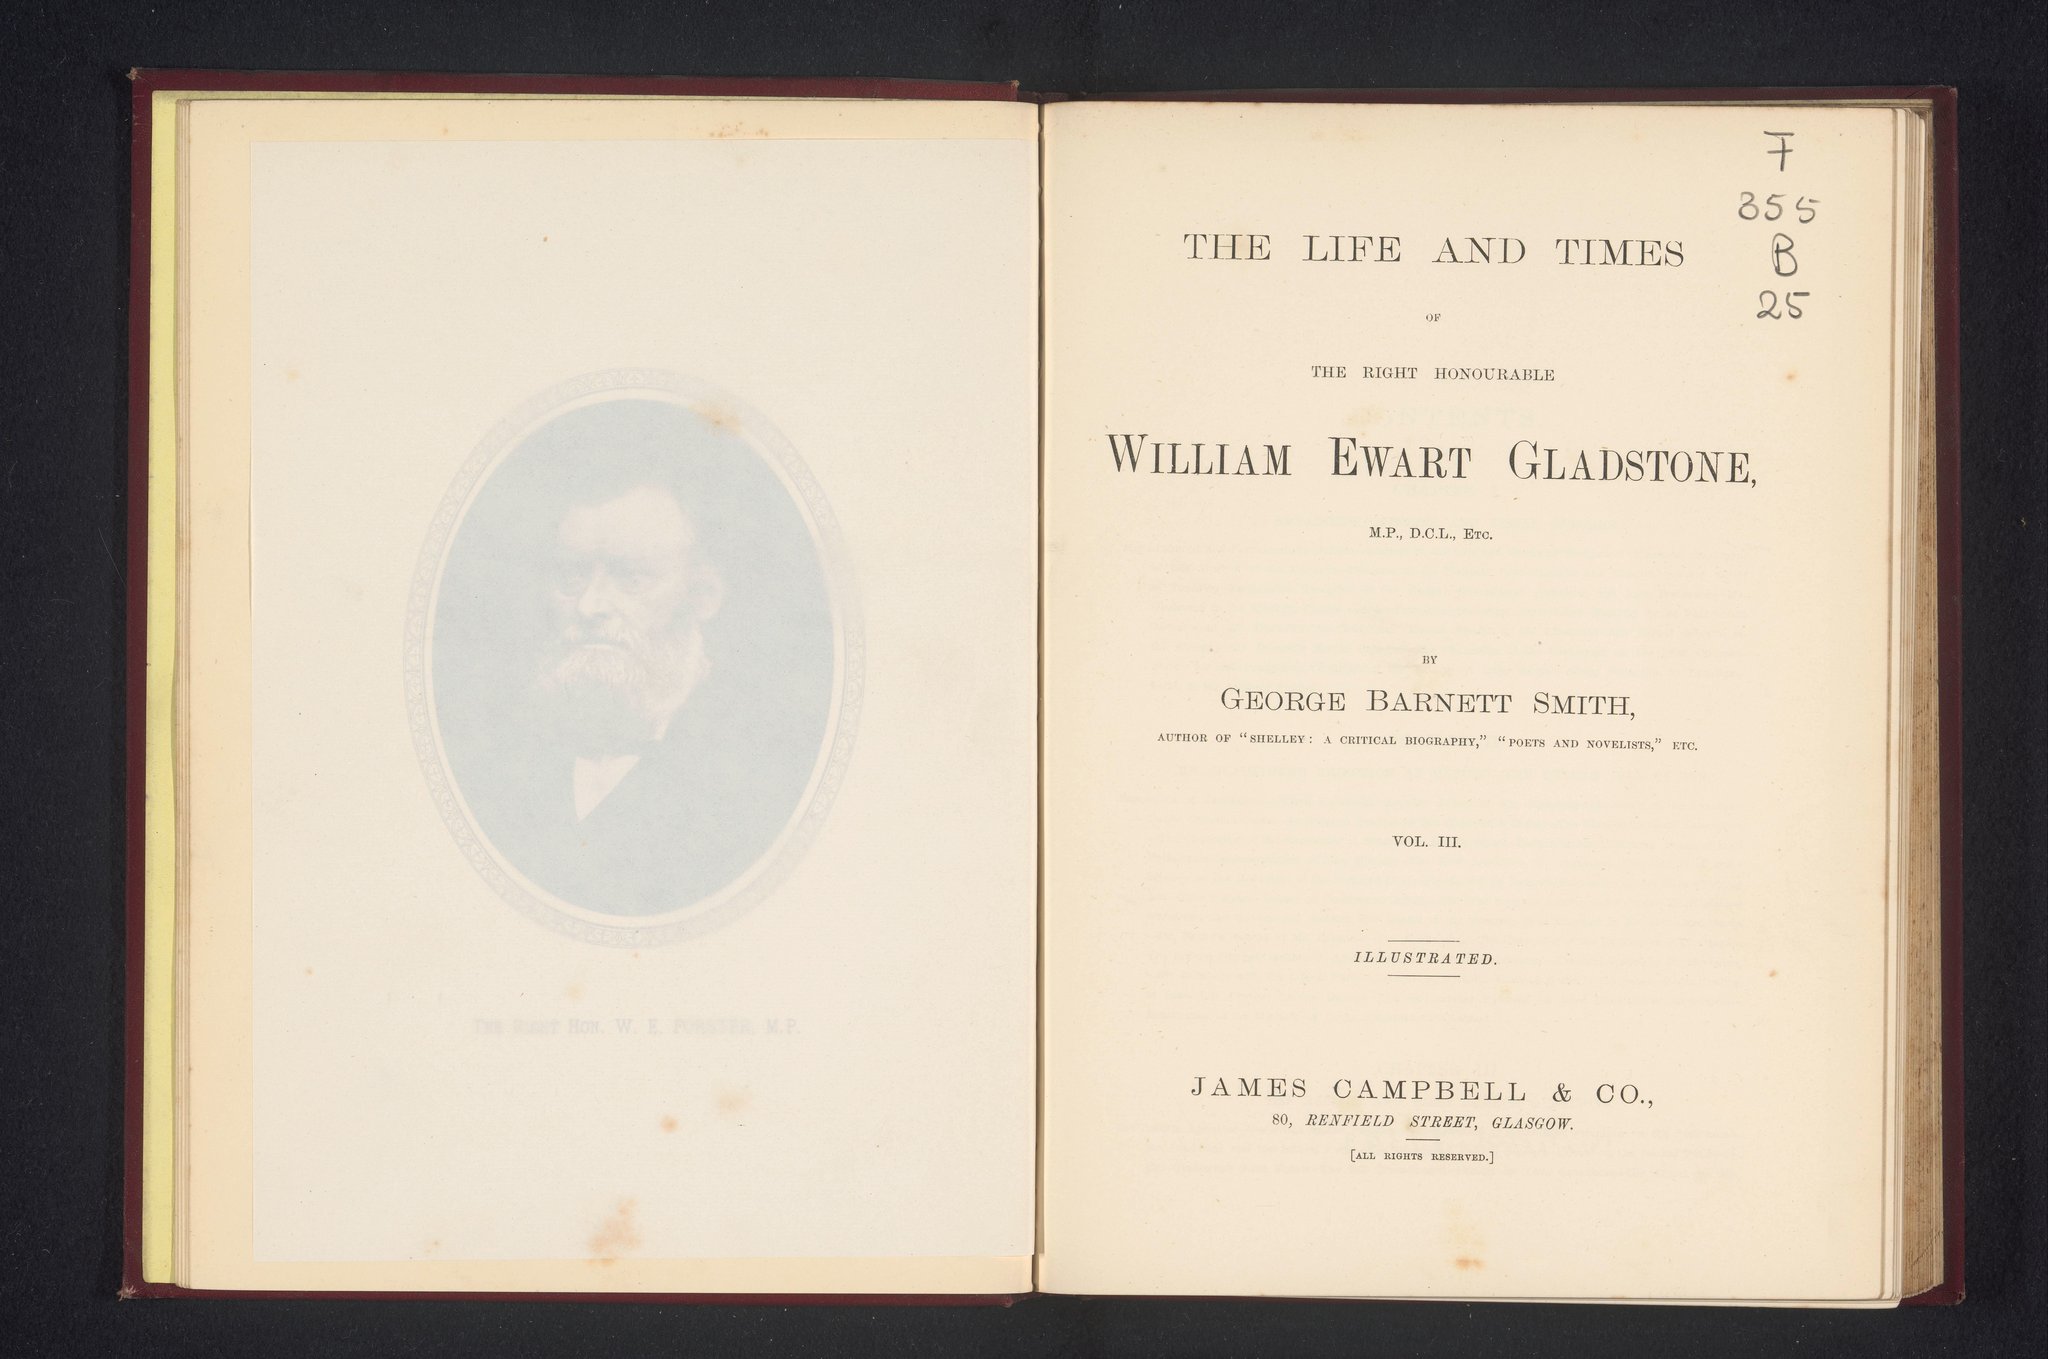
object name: book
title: The life and times of the Right Honourable William Ewart Gladstone volume III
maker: george barnett smith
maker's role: auteur, journalist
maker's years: 1841-1909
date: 1880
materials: cardboard, linen, paper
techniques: printing, woodburytype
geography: glasgow